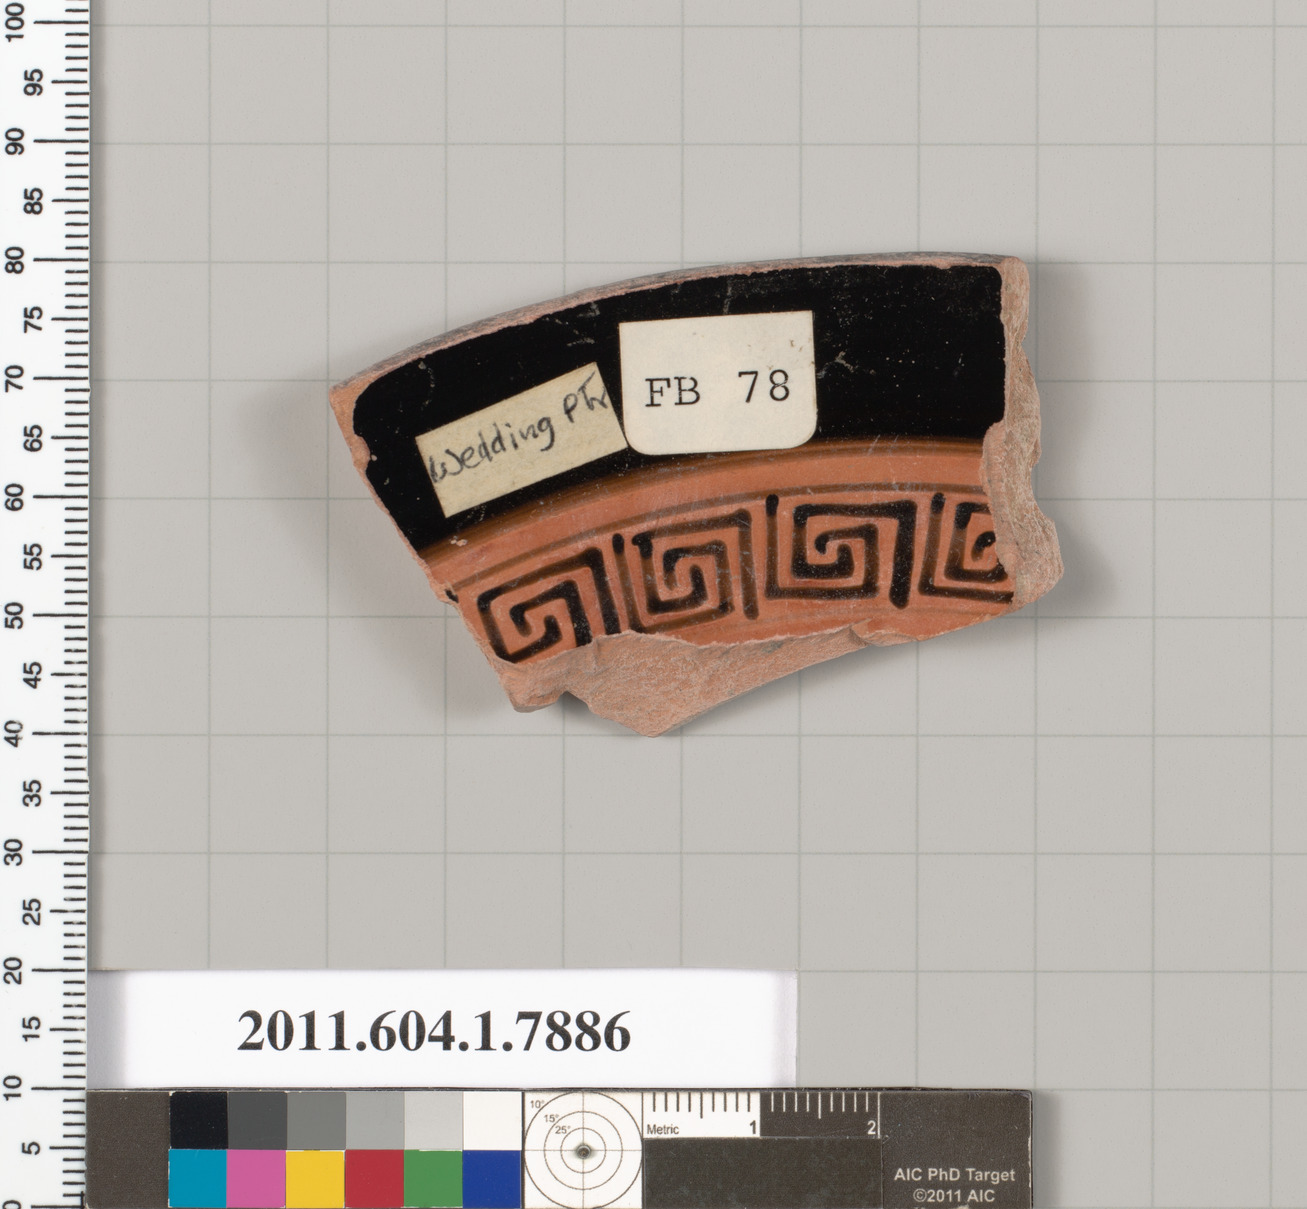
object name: kylix fragment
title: Terracotta fragment of a kylix (drinking cup)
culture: greek, attic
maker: wedding painter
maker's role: artist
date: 460-450 BCE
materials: terracotta